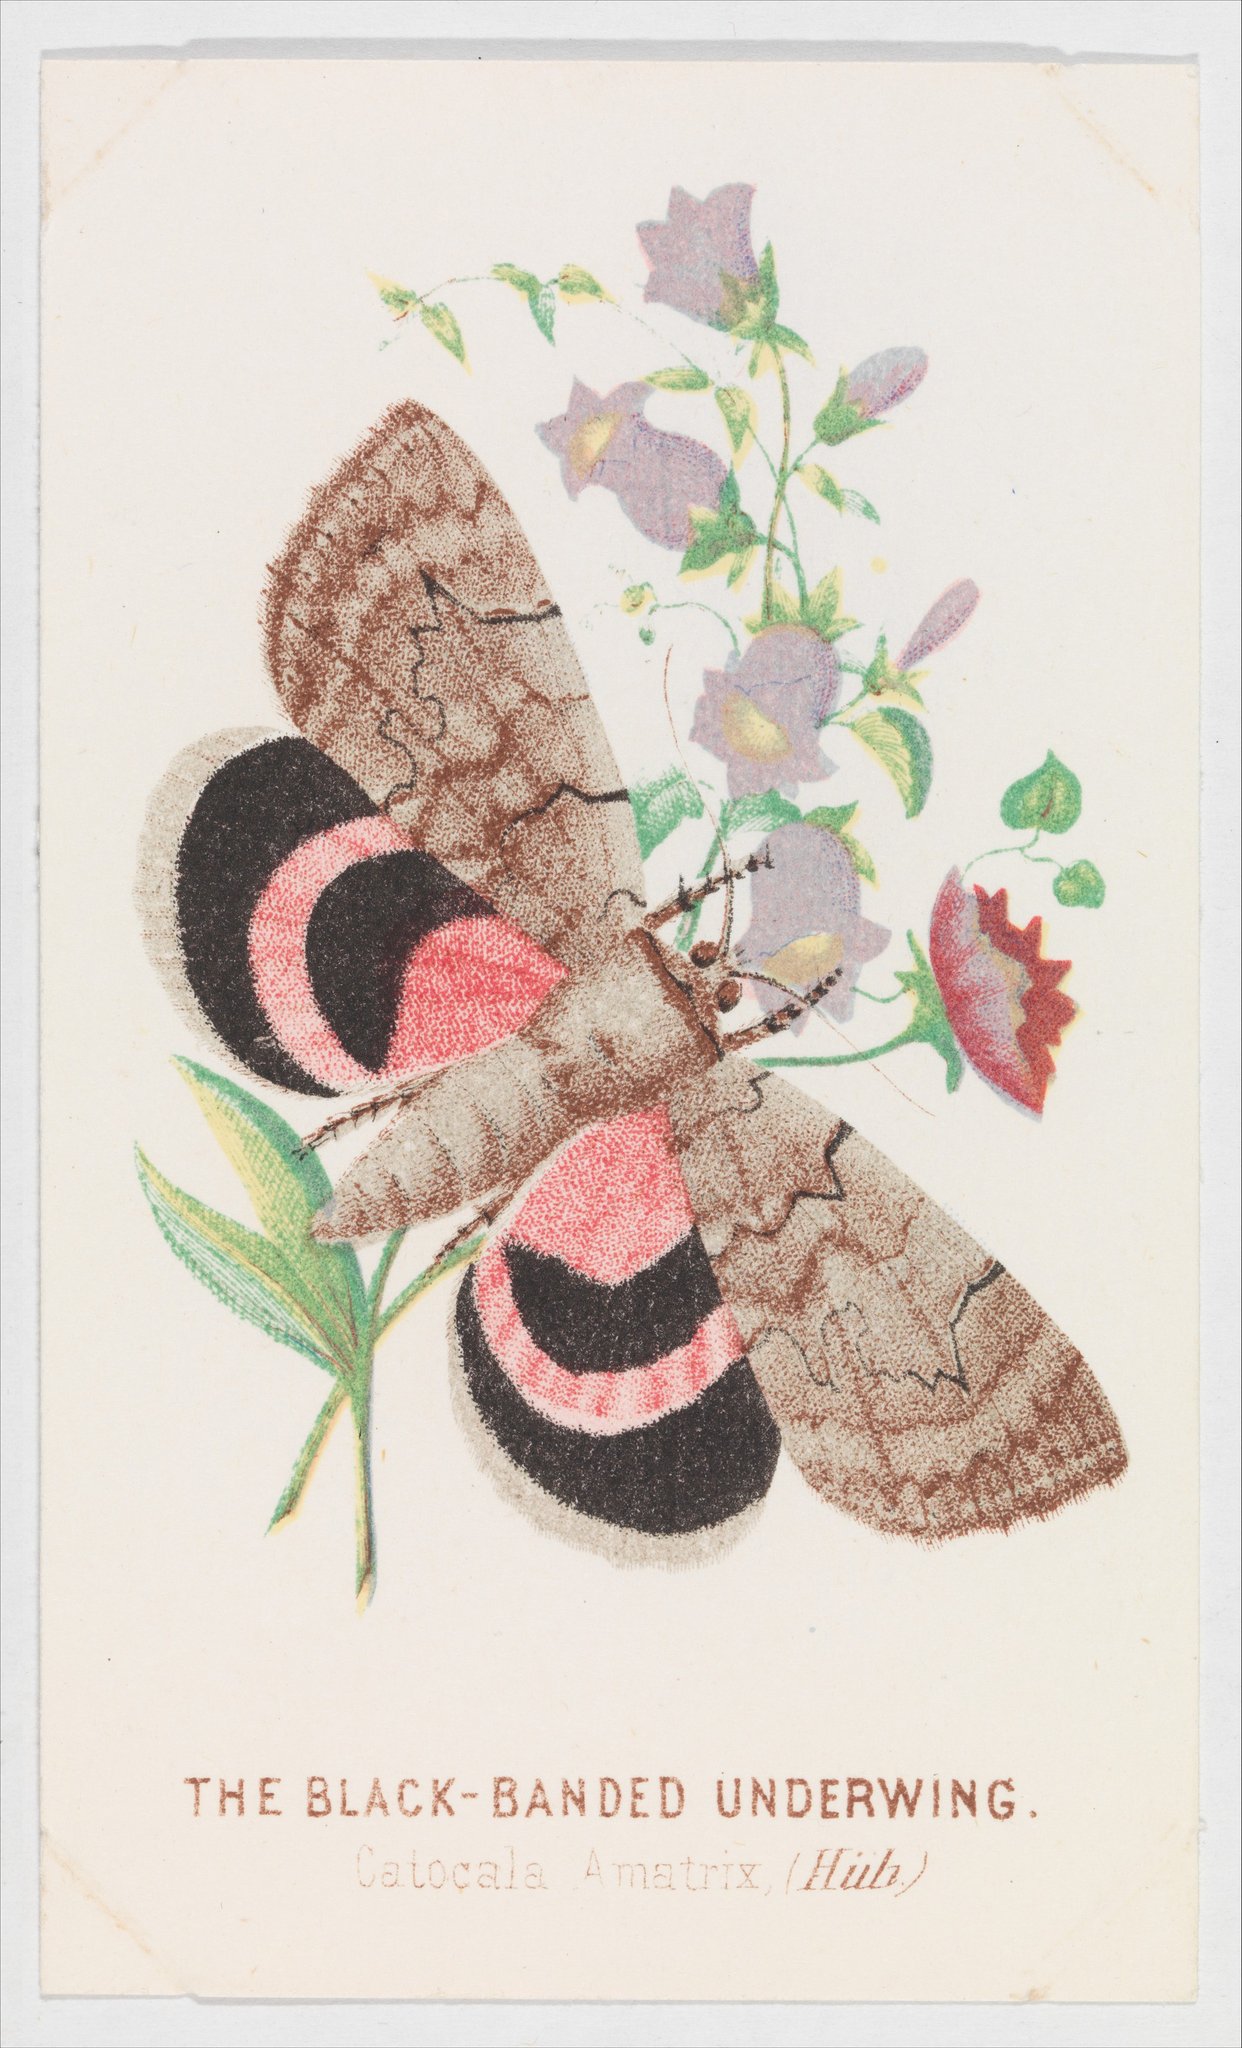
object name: print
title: The Black-Banded Underwing, from "The Butterflies and Moths of America", Part 2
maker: louis prang & co.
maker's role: publisher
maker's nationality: american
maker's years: 1800-1950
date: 1862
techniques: lithograph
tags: insects,flowers